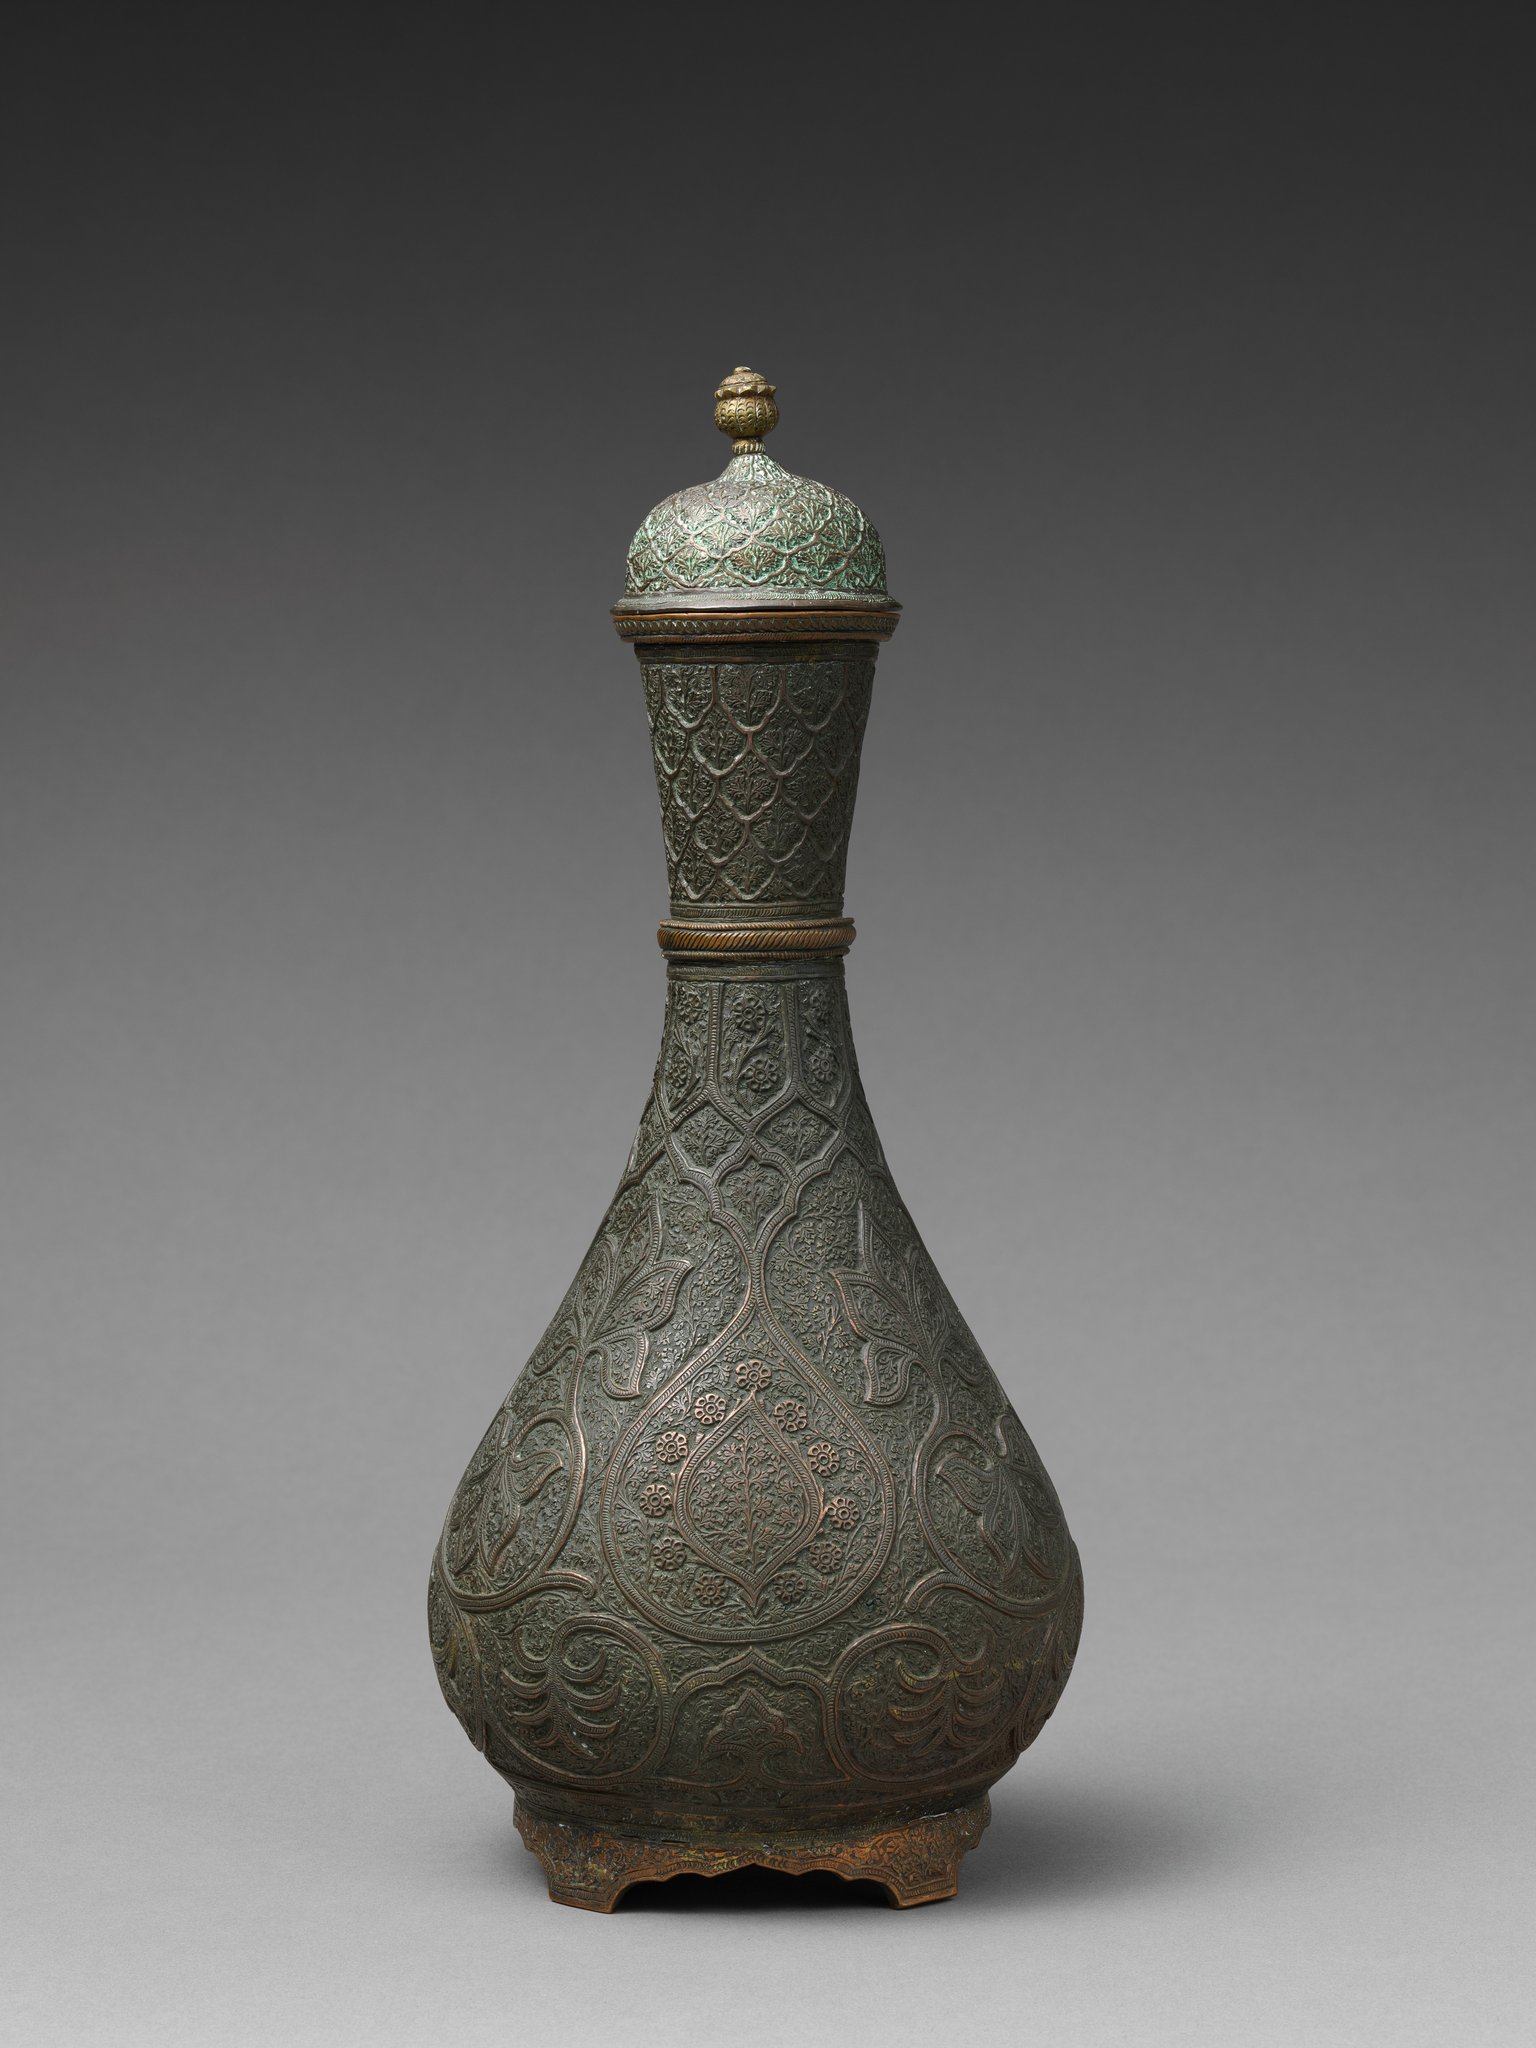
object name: bottle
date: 1701-1900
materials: copper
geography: india